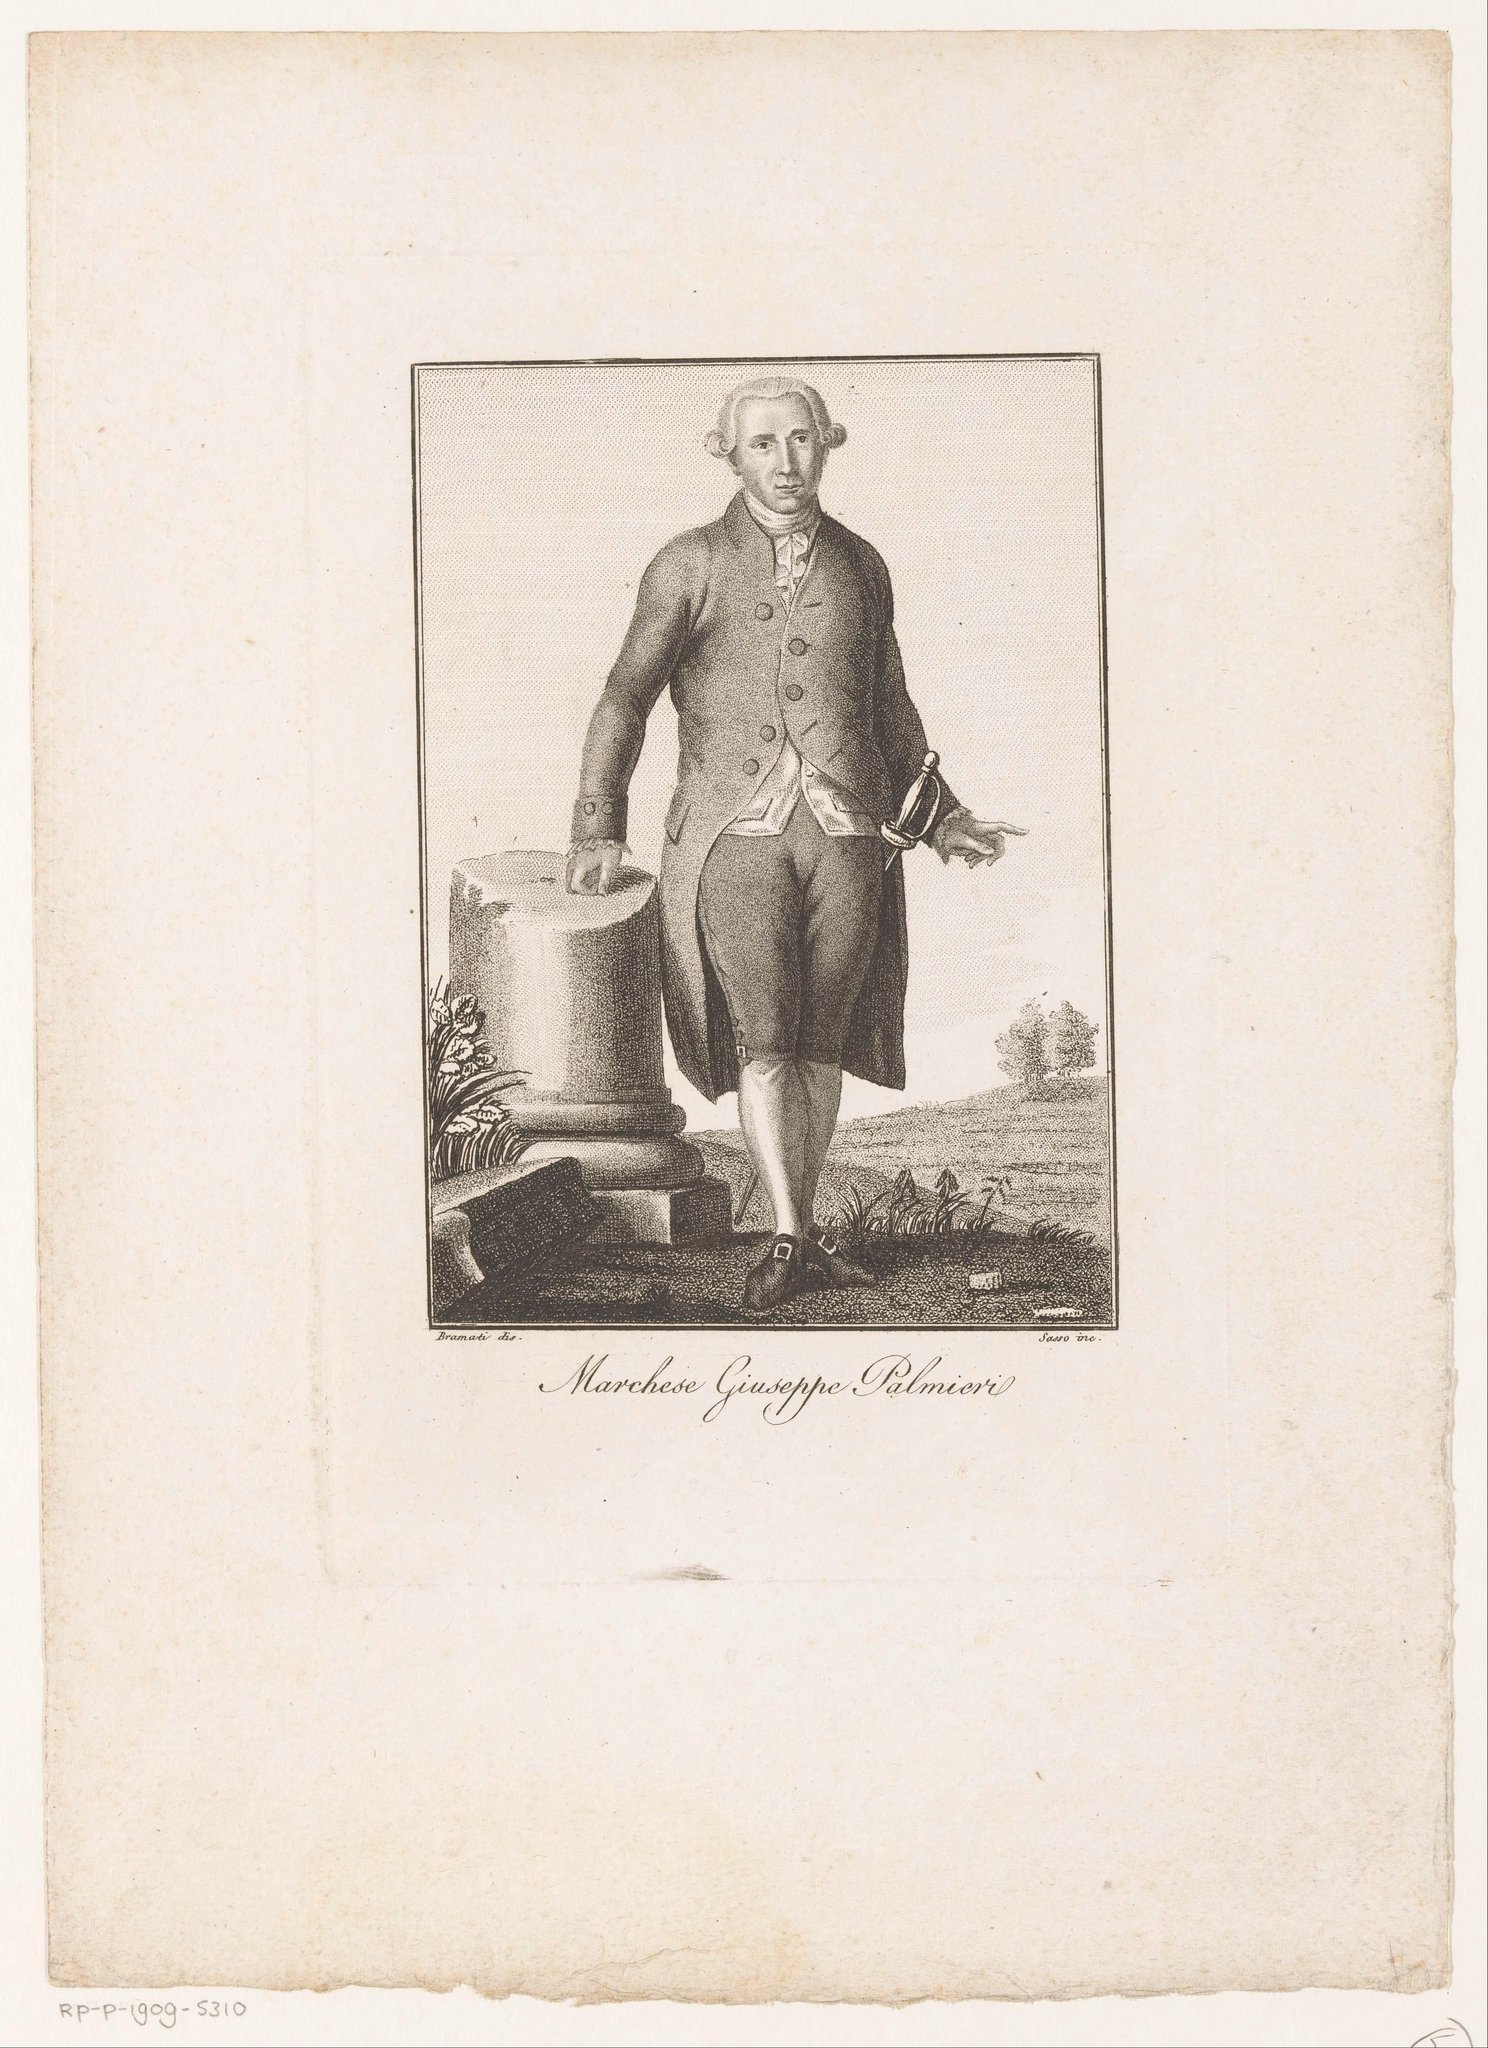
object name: print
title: Portret van econoom Giuseppe Palmieri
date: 1809-1816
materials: paper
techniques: engraving, etching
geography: italy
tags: martignano, naples, historical persons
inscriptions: collector's mark: Lugt 2228